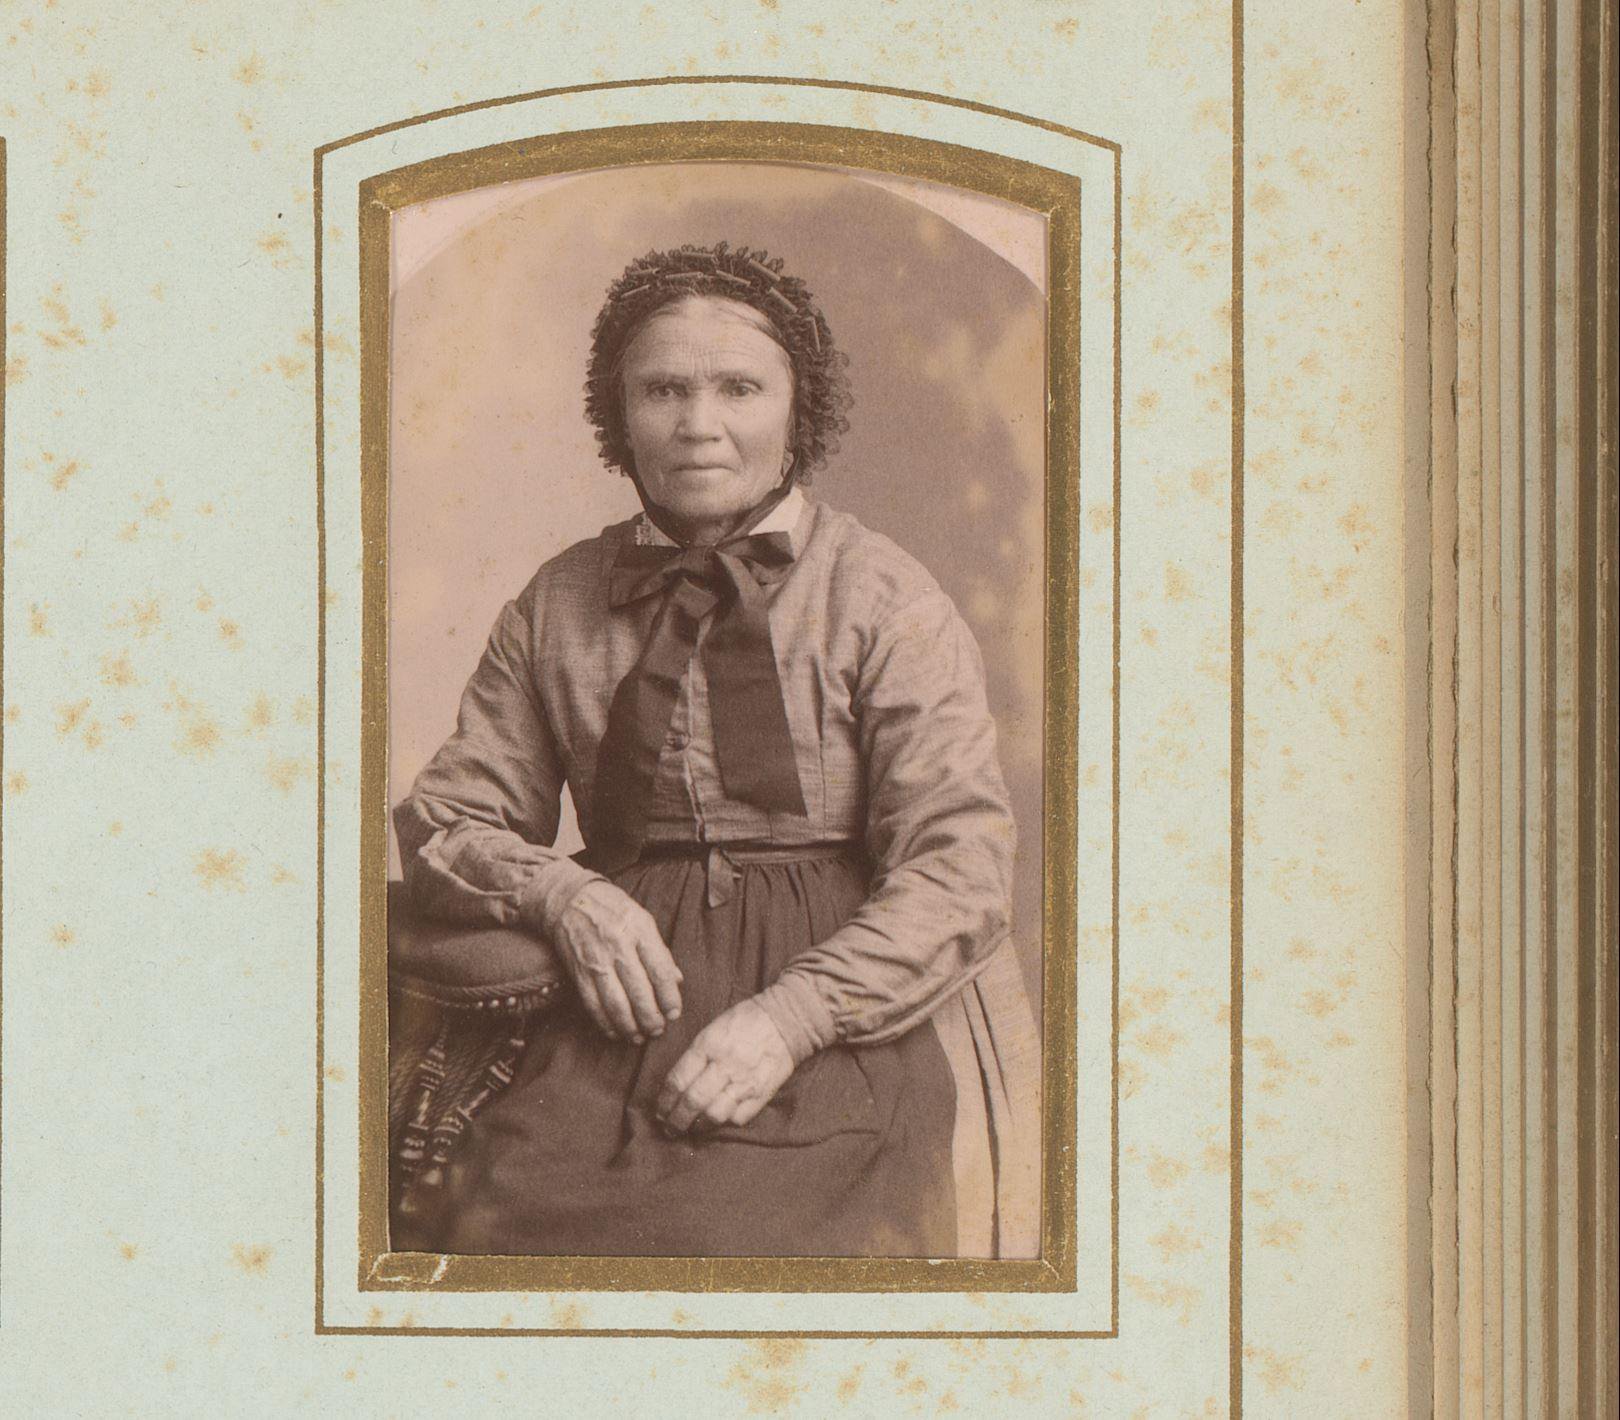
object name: album leaf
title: Portret van een oude vrouw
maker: Anonymous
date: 1880-1900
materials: cardboard, photographic support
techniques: albumen print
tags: historical persons - bb - woman, old woman